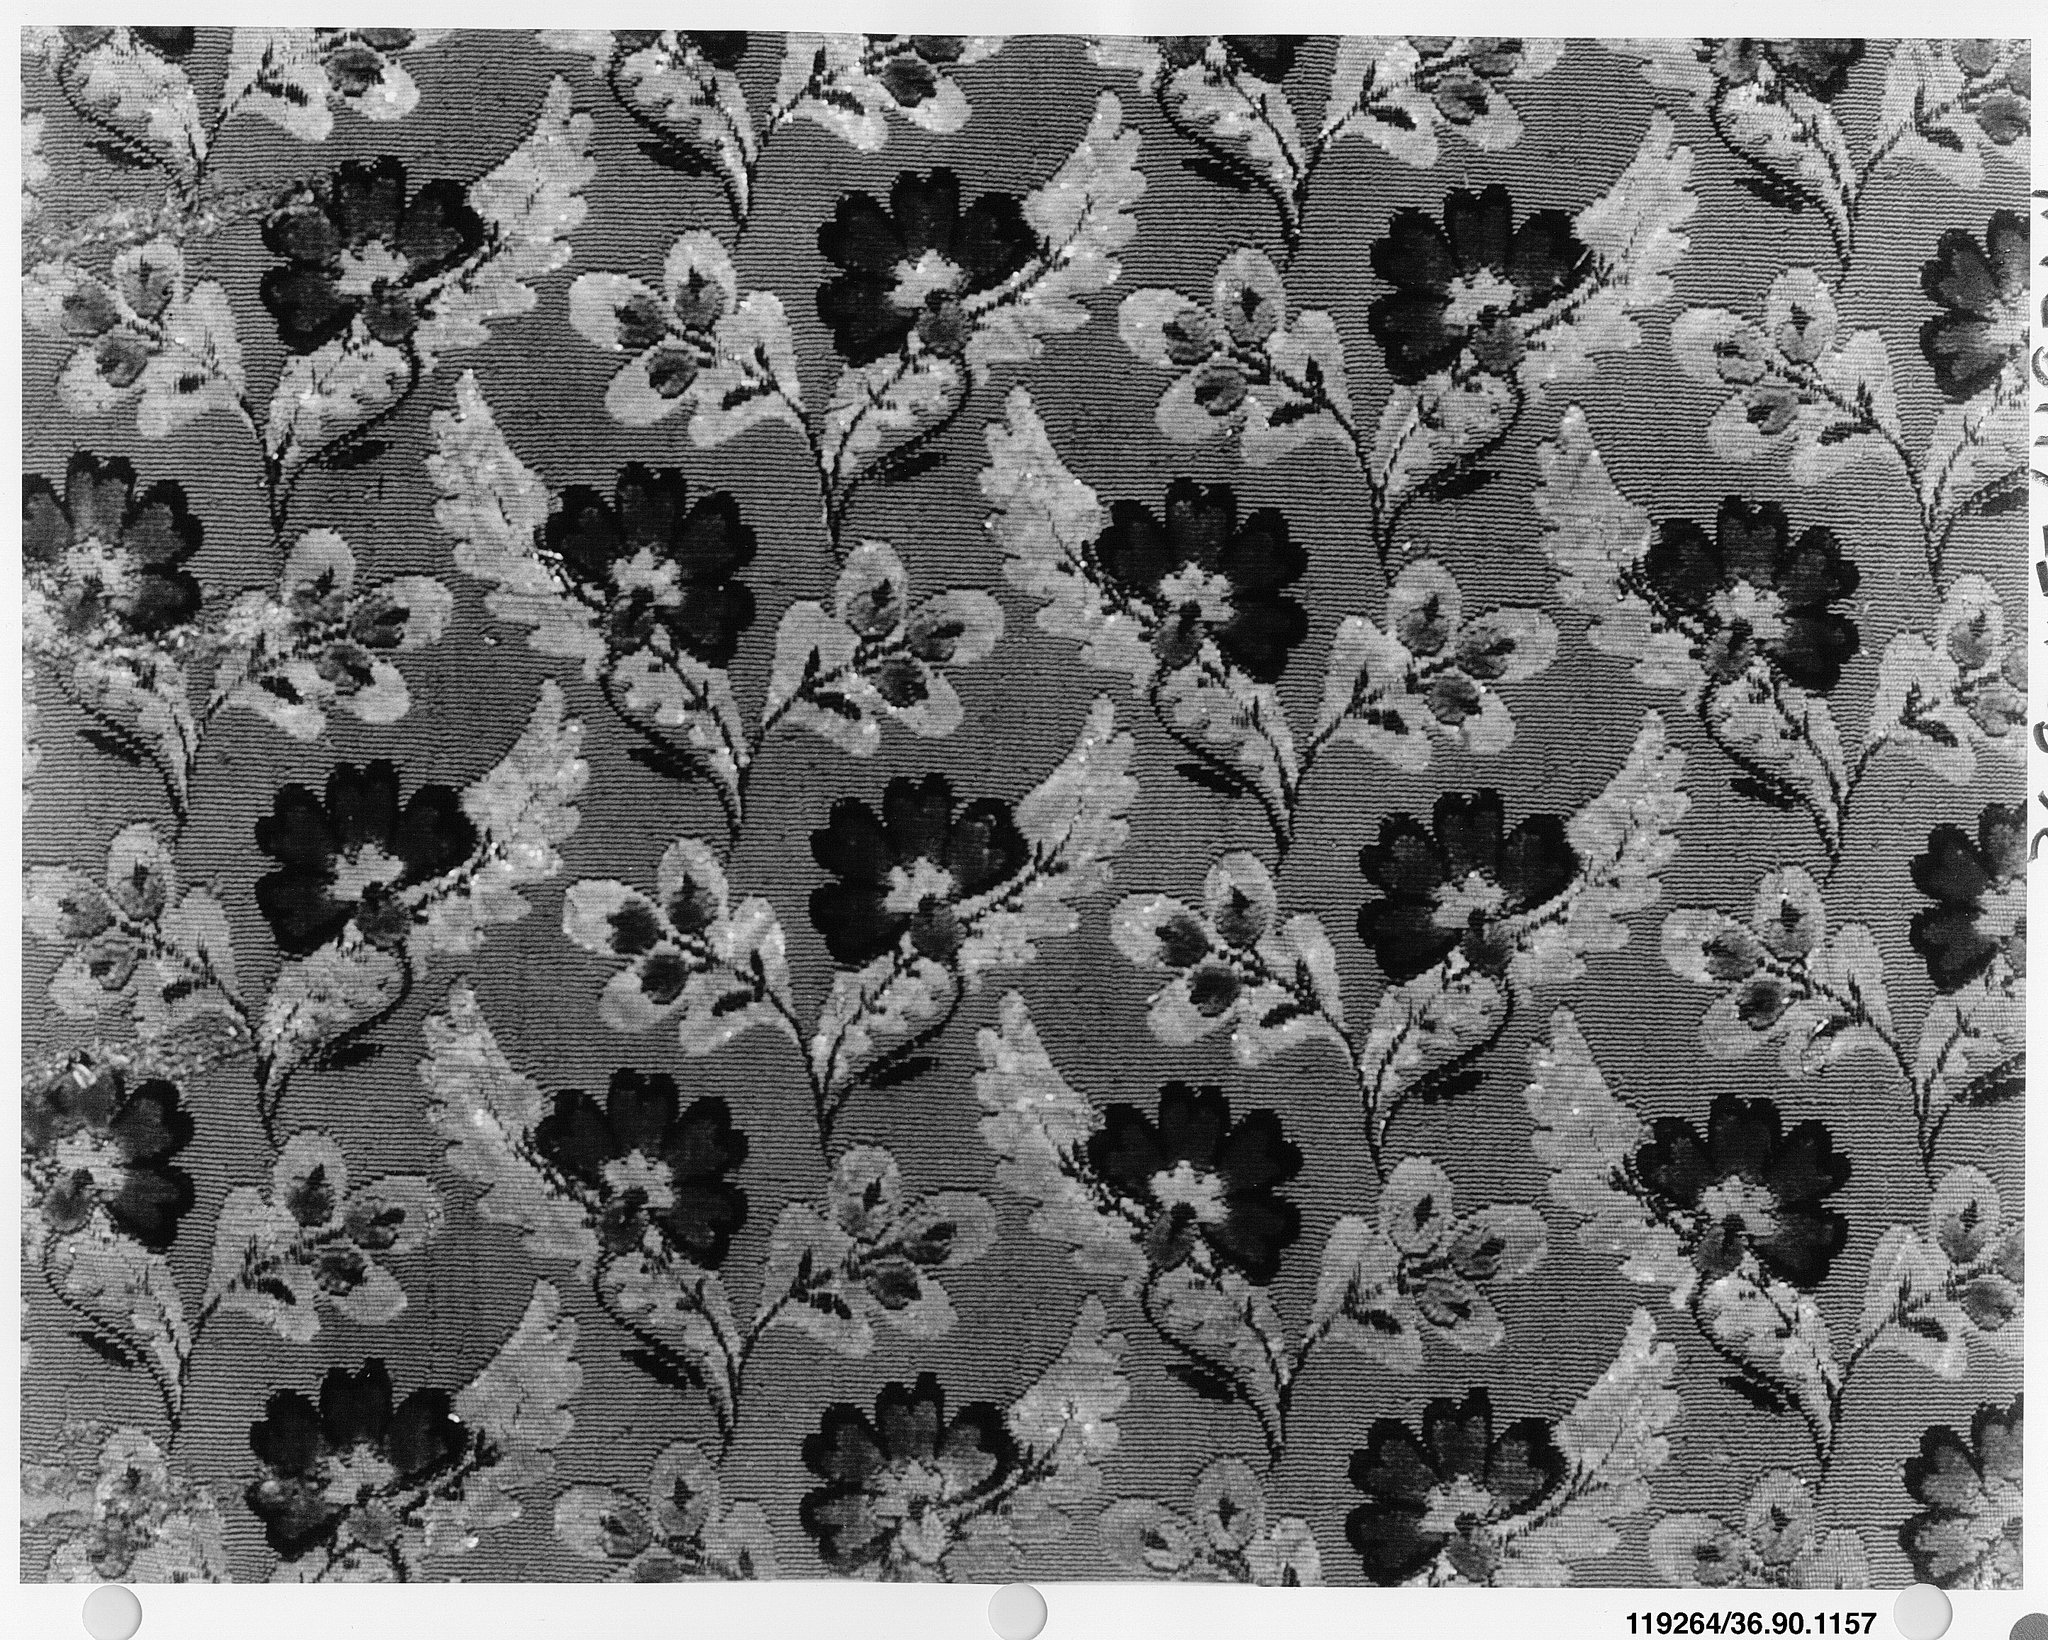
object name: piece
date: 1701-1800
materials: metal thread, silk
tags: flowers,leaves